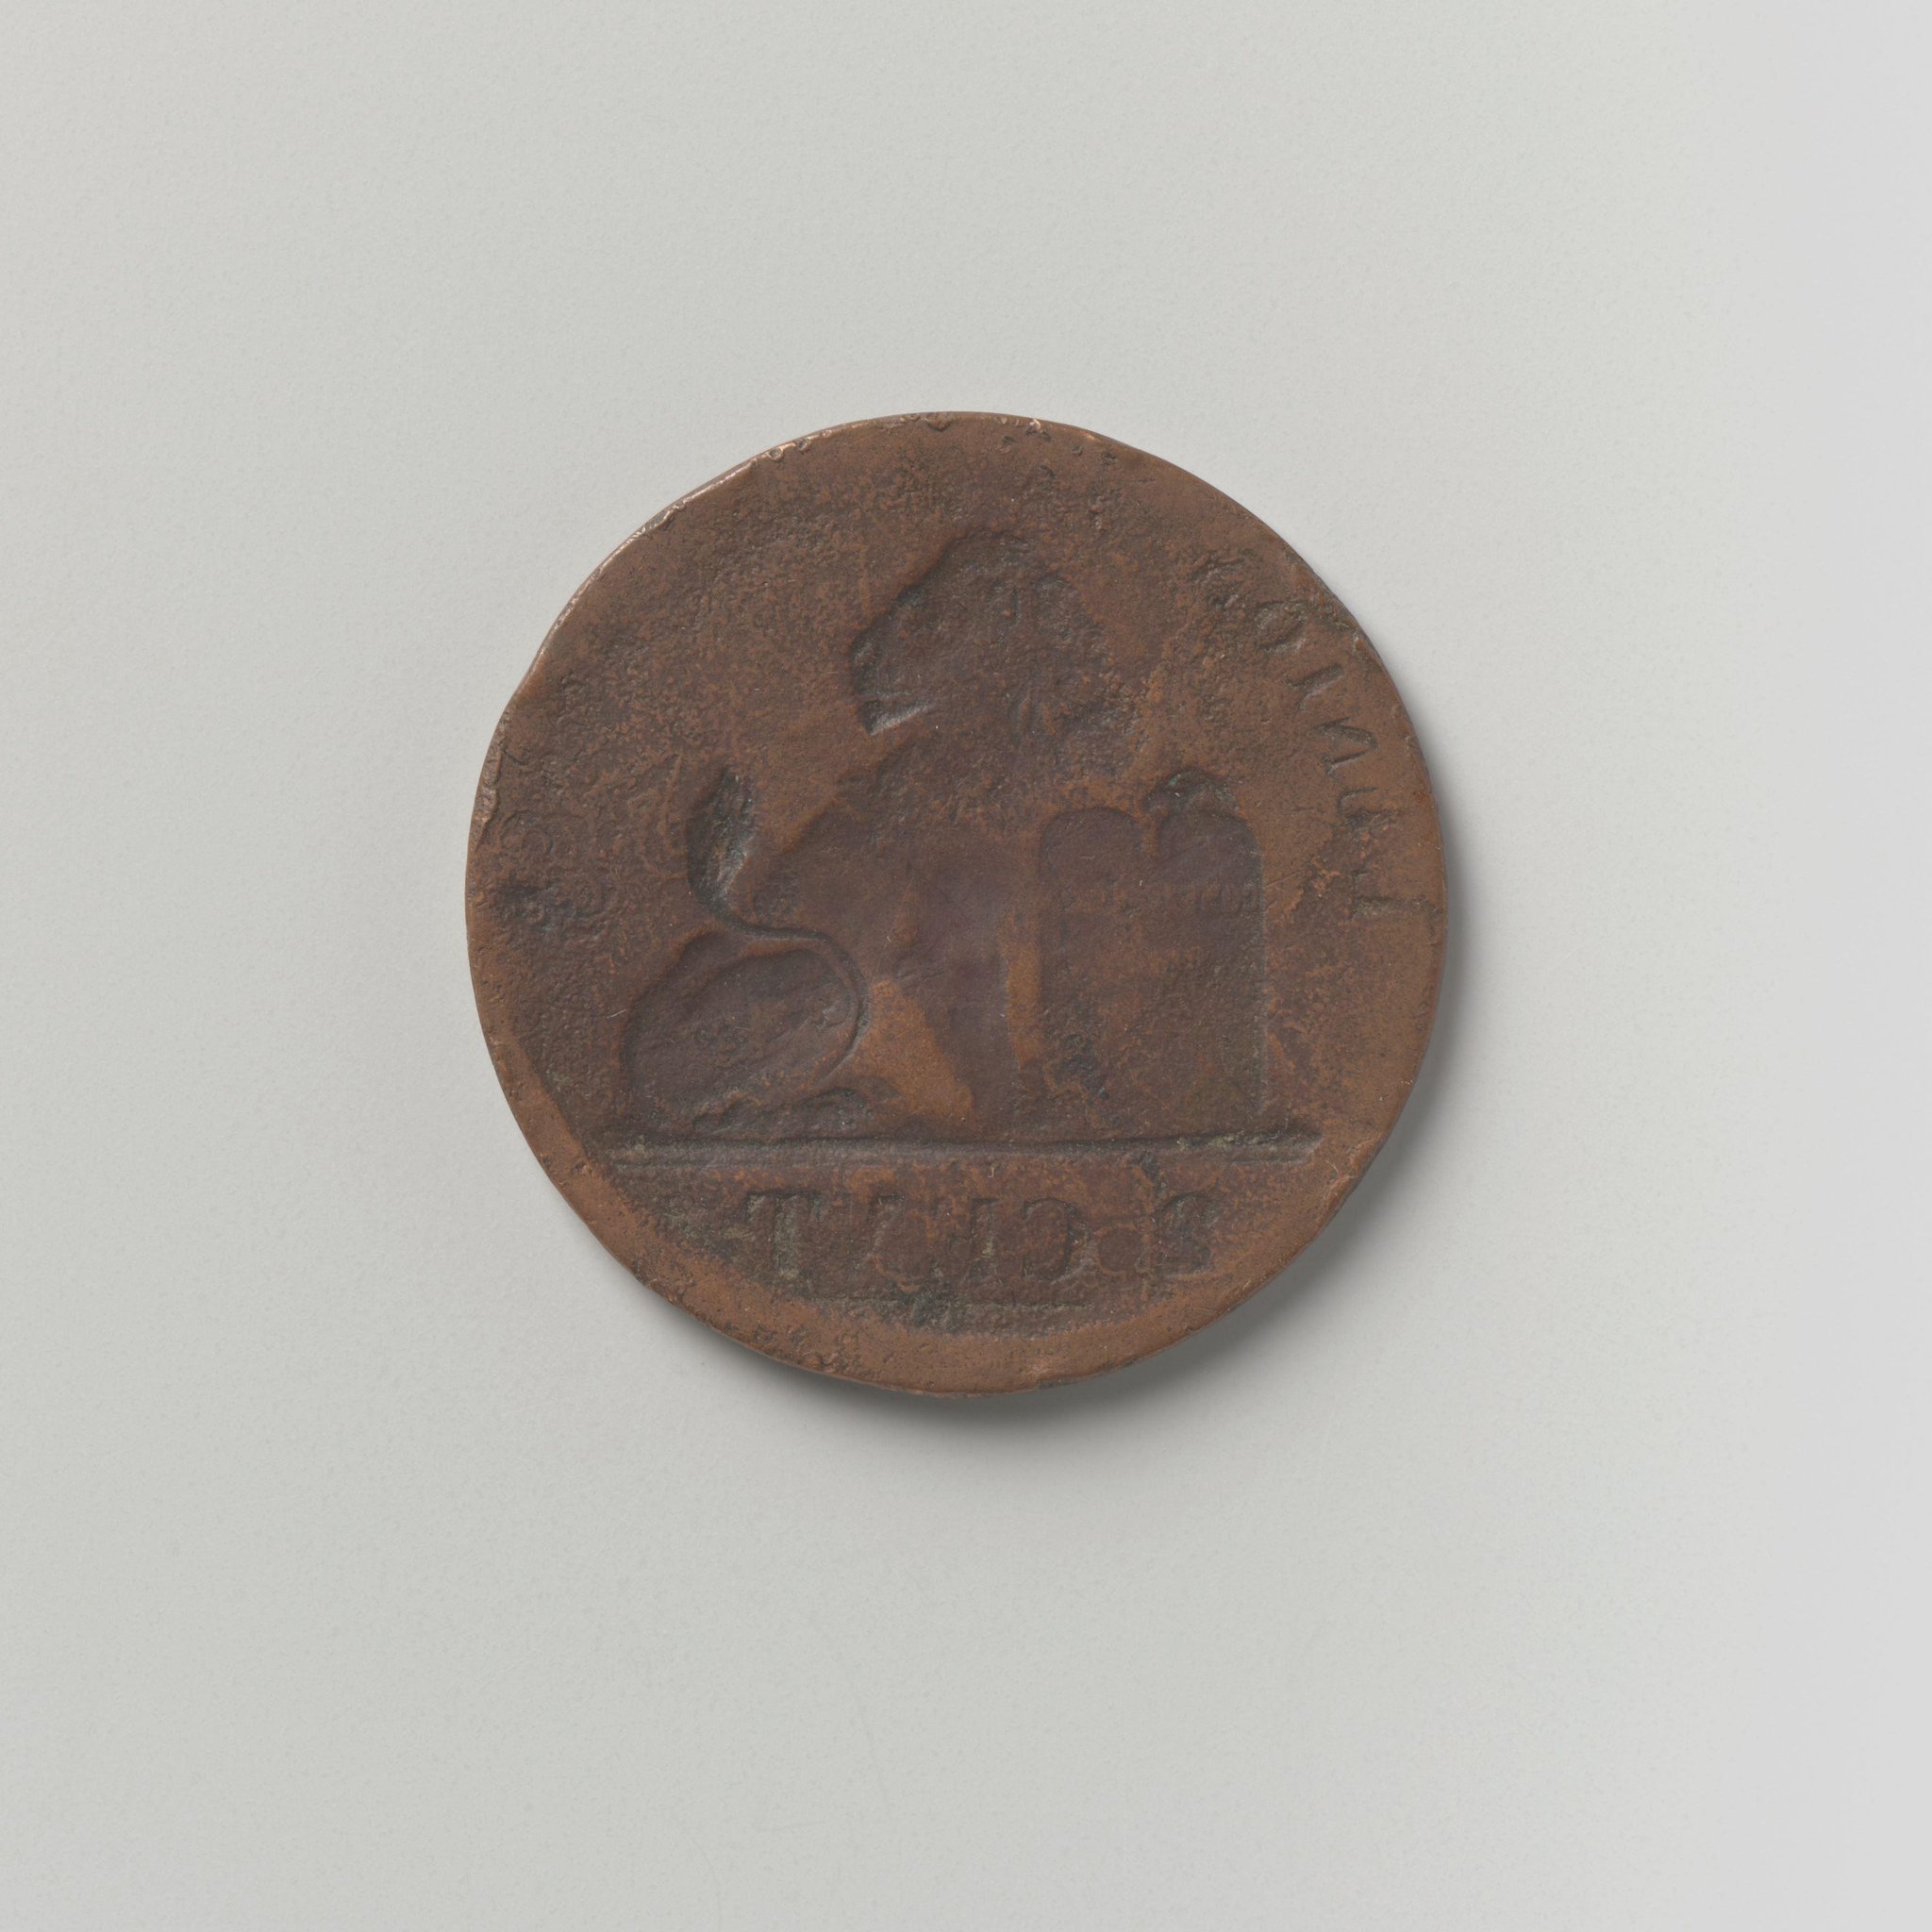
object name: twee centime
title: 2 centimes uit België van Leopold I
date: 1832-1865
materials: copper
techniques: striking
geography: brussels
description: Koperen munt. Voorzijde: zittende, omkijkende leeuw naar links met onder rechter klauw paneel met opschrift. In afsnede waarde-aanduiding. Keerzijde: voorzijde incusum. Kartelrand.